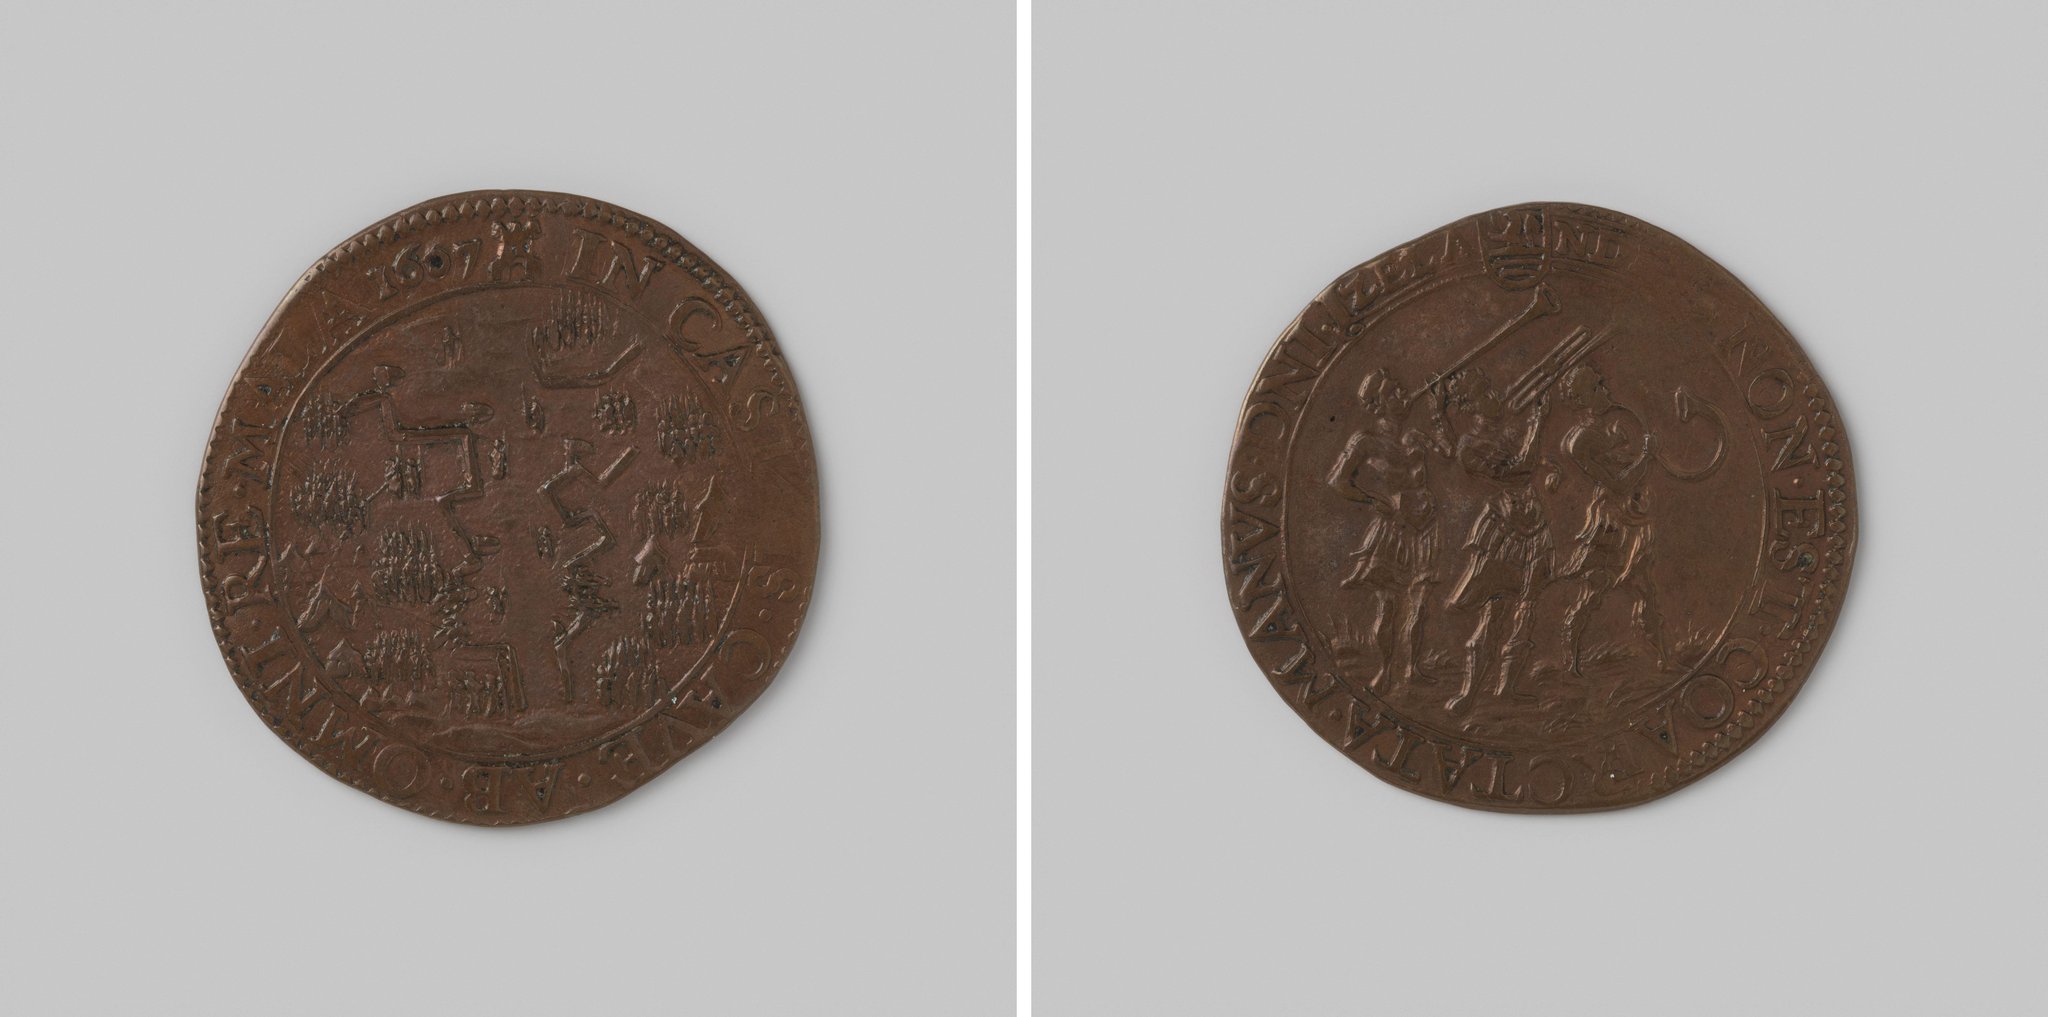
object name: jeton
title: Rekenpenning uit Middelburg op het begin van vredesonderhandelingen 1607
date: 1607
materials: copper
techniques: striking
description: Koperen penning, op de voorzijde twee legers binnen hun verschansingen in vogelvlucht, met omschrift, op de keerzijde drie hoornblazers met omschrift.